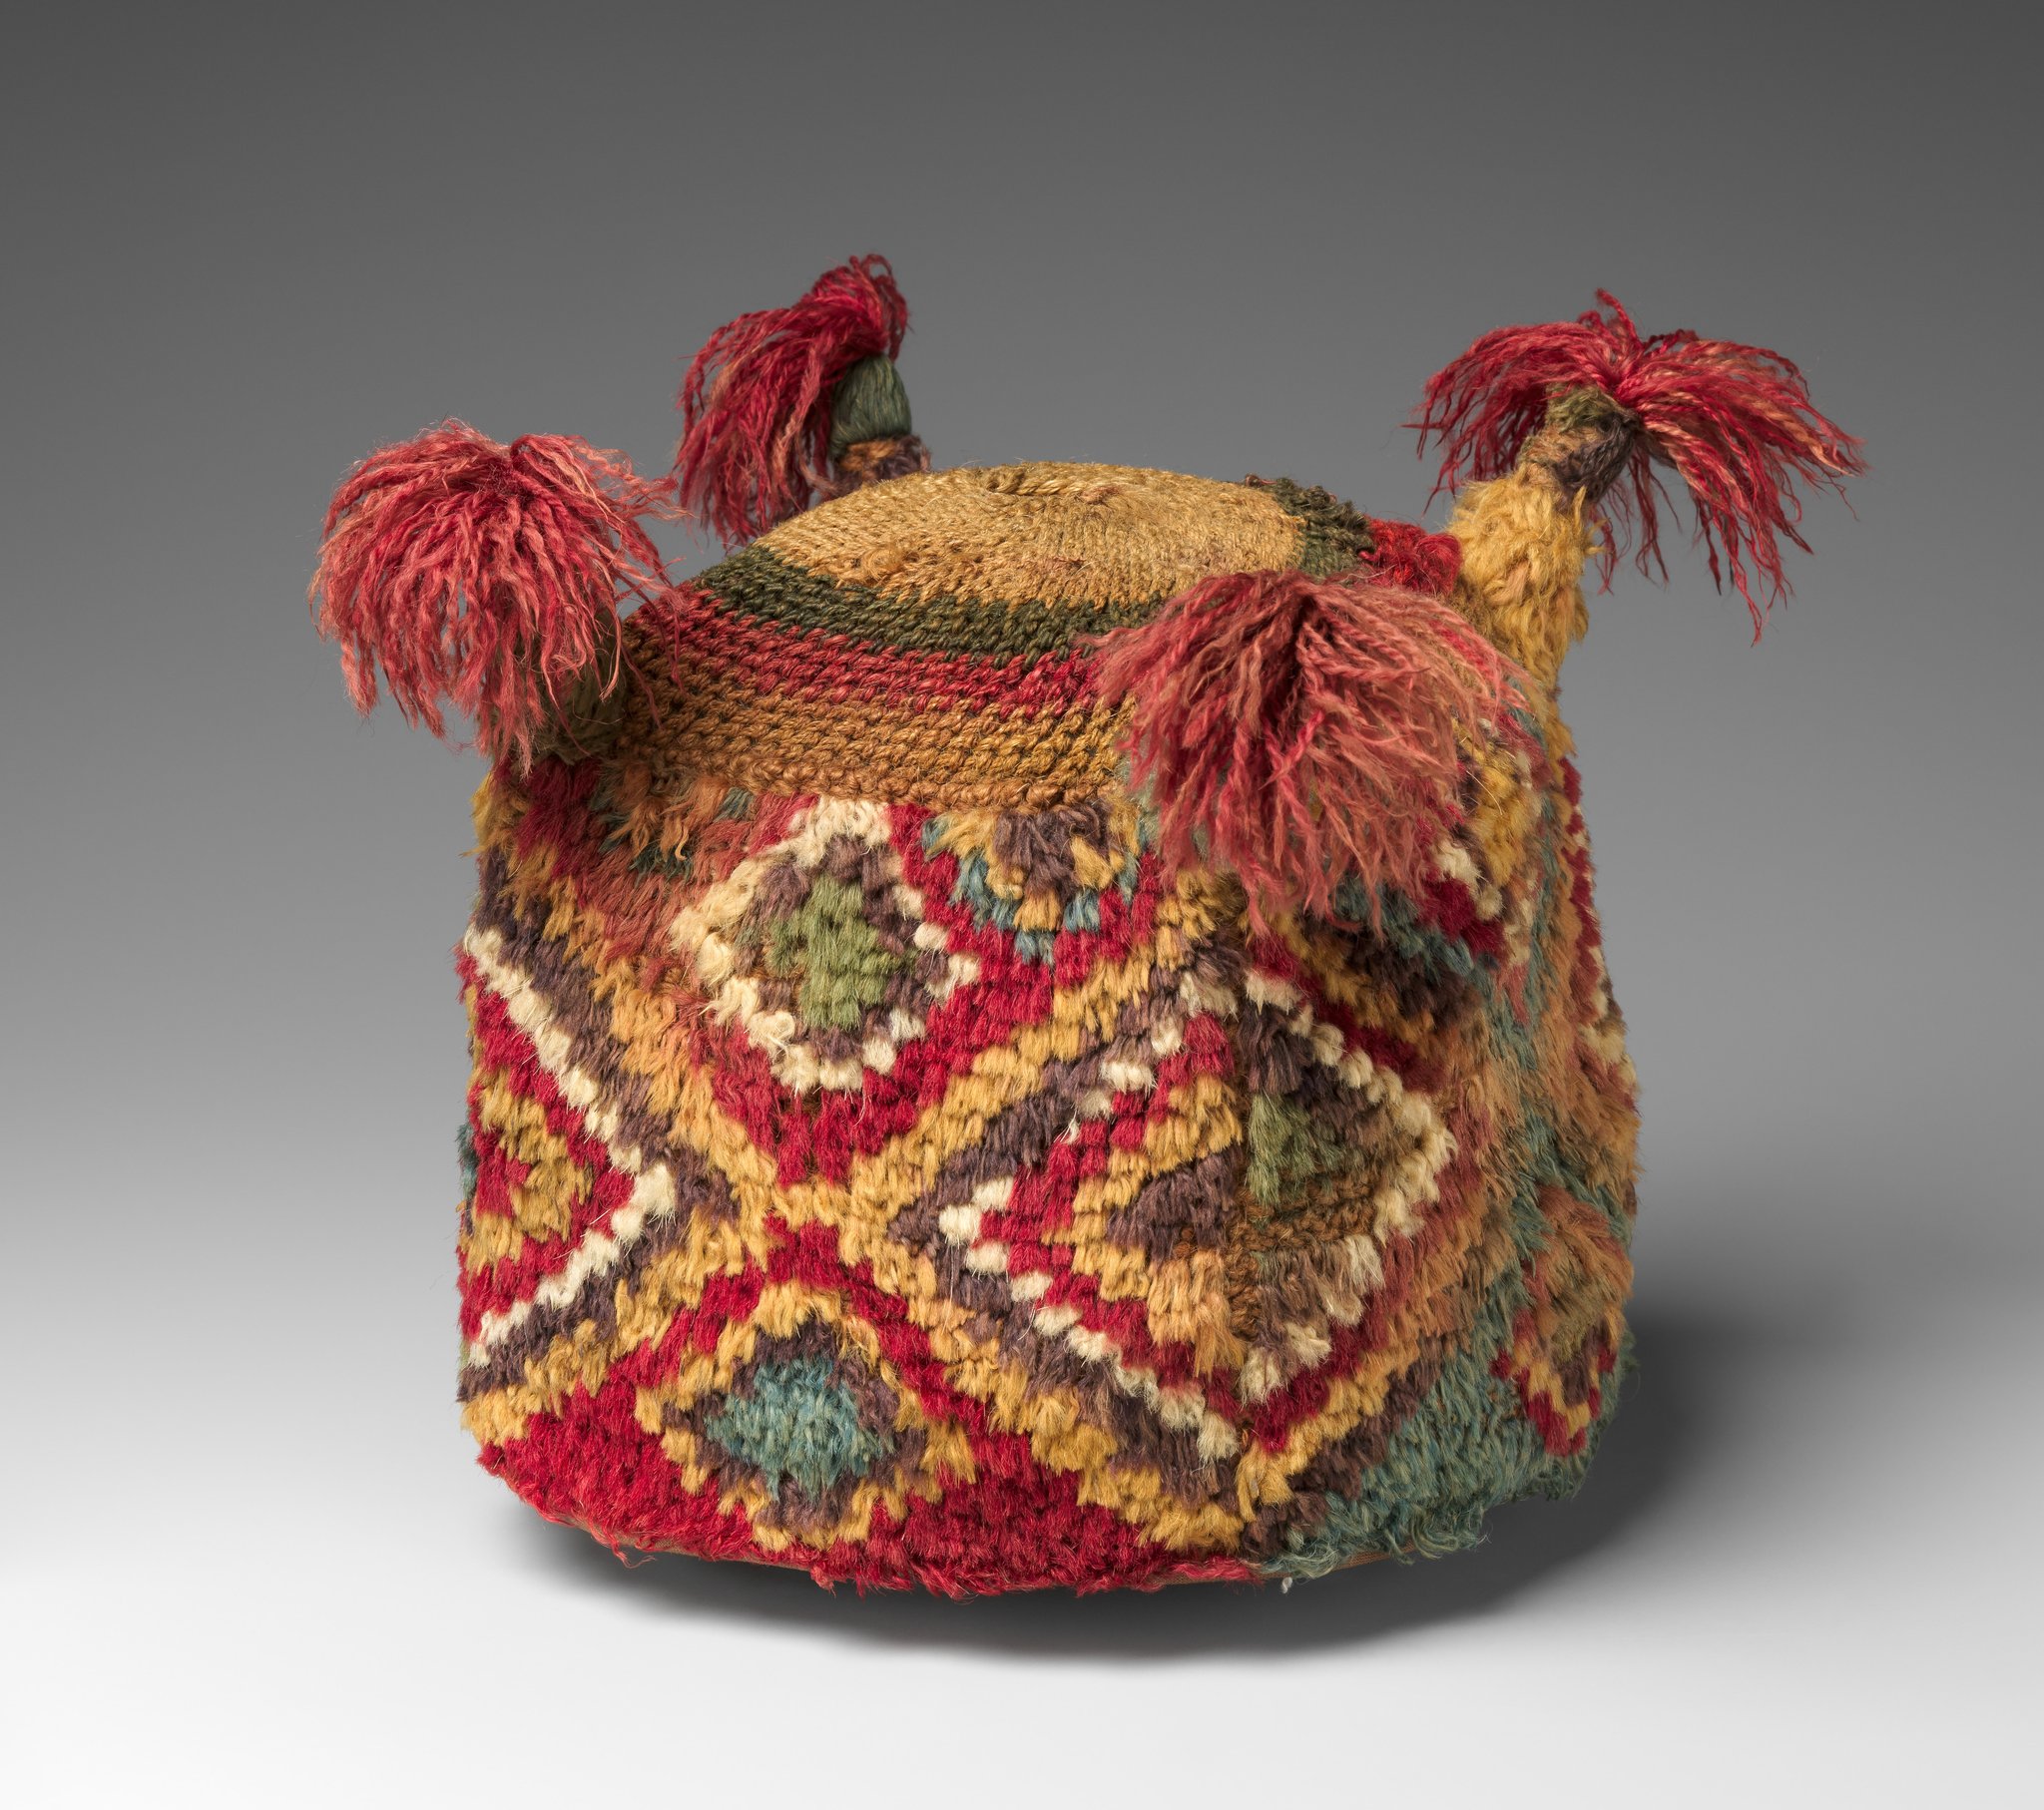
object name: hat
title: Four-Cornered Hat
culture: wari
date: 701-1000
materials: animal fiber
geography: peru